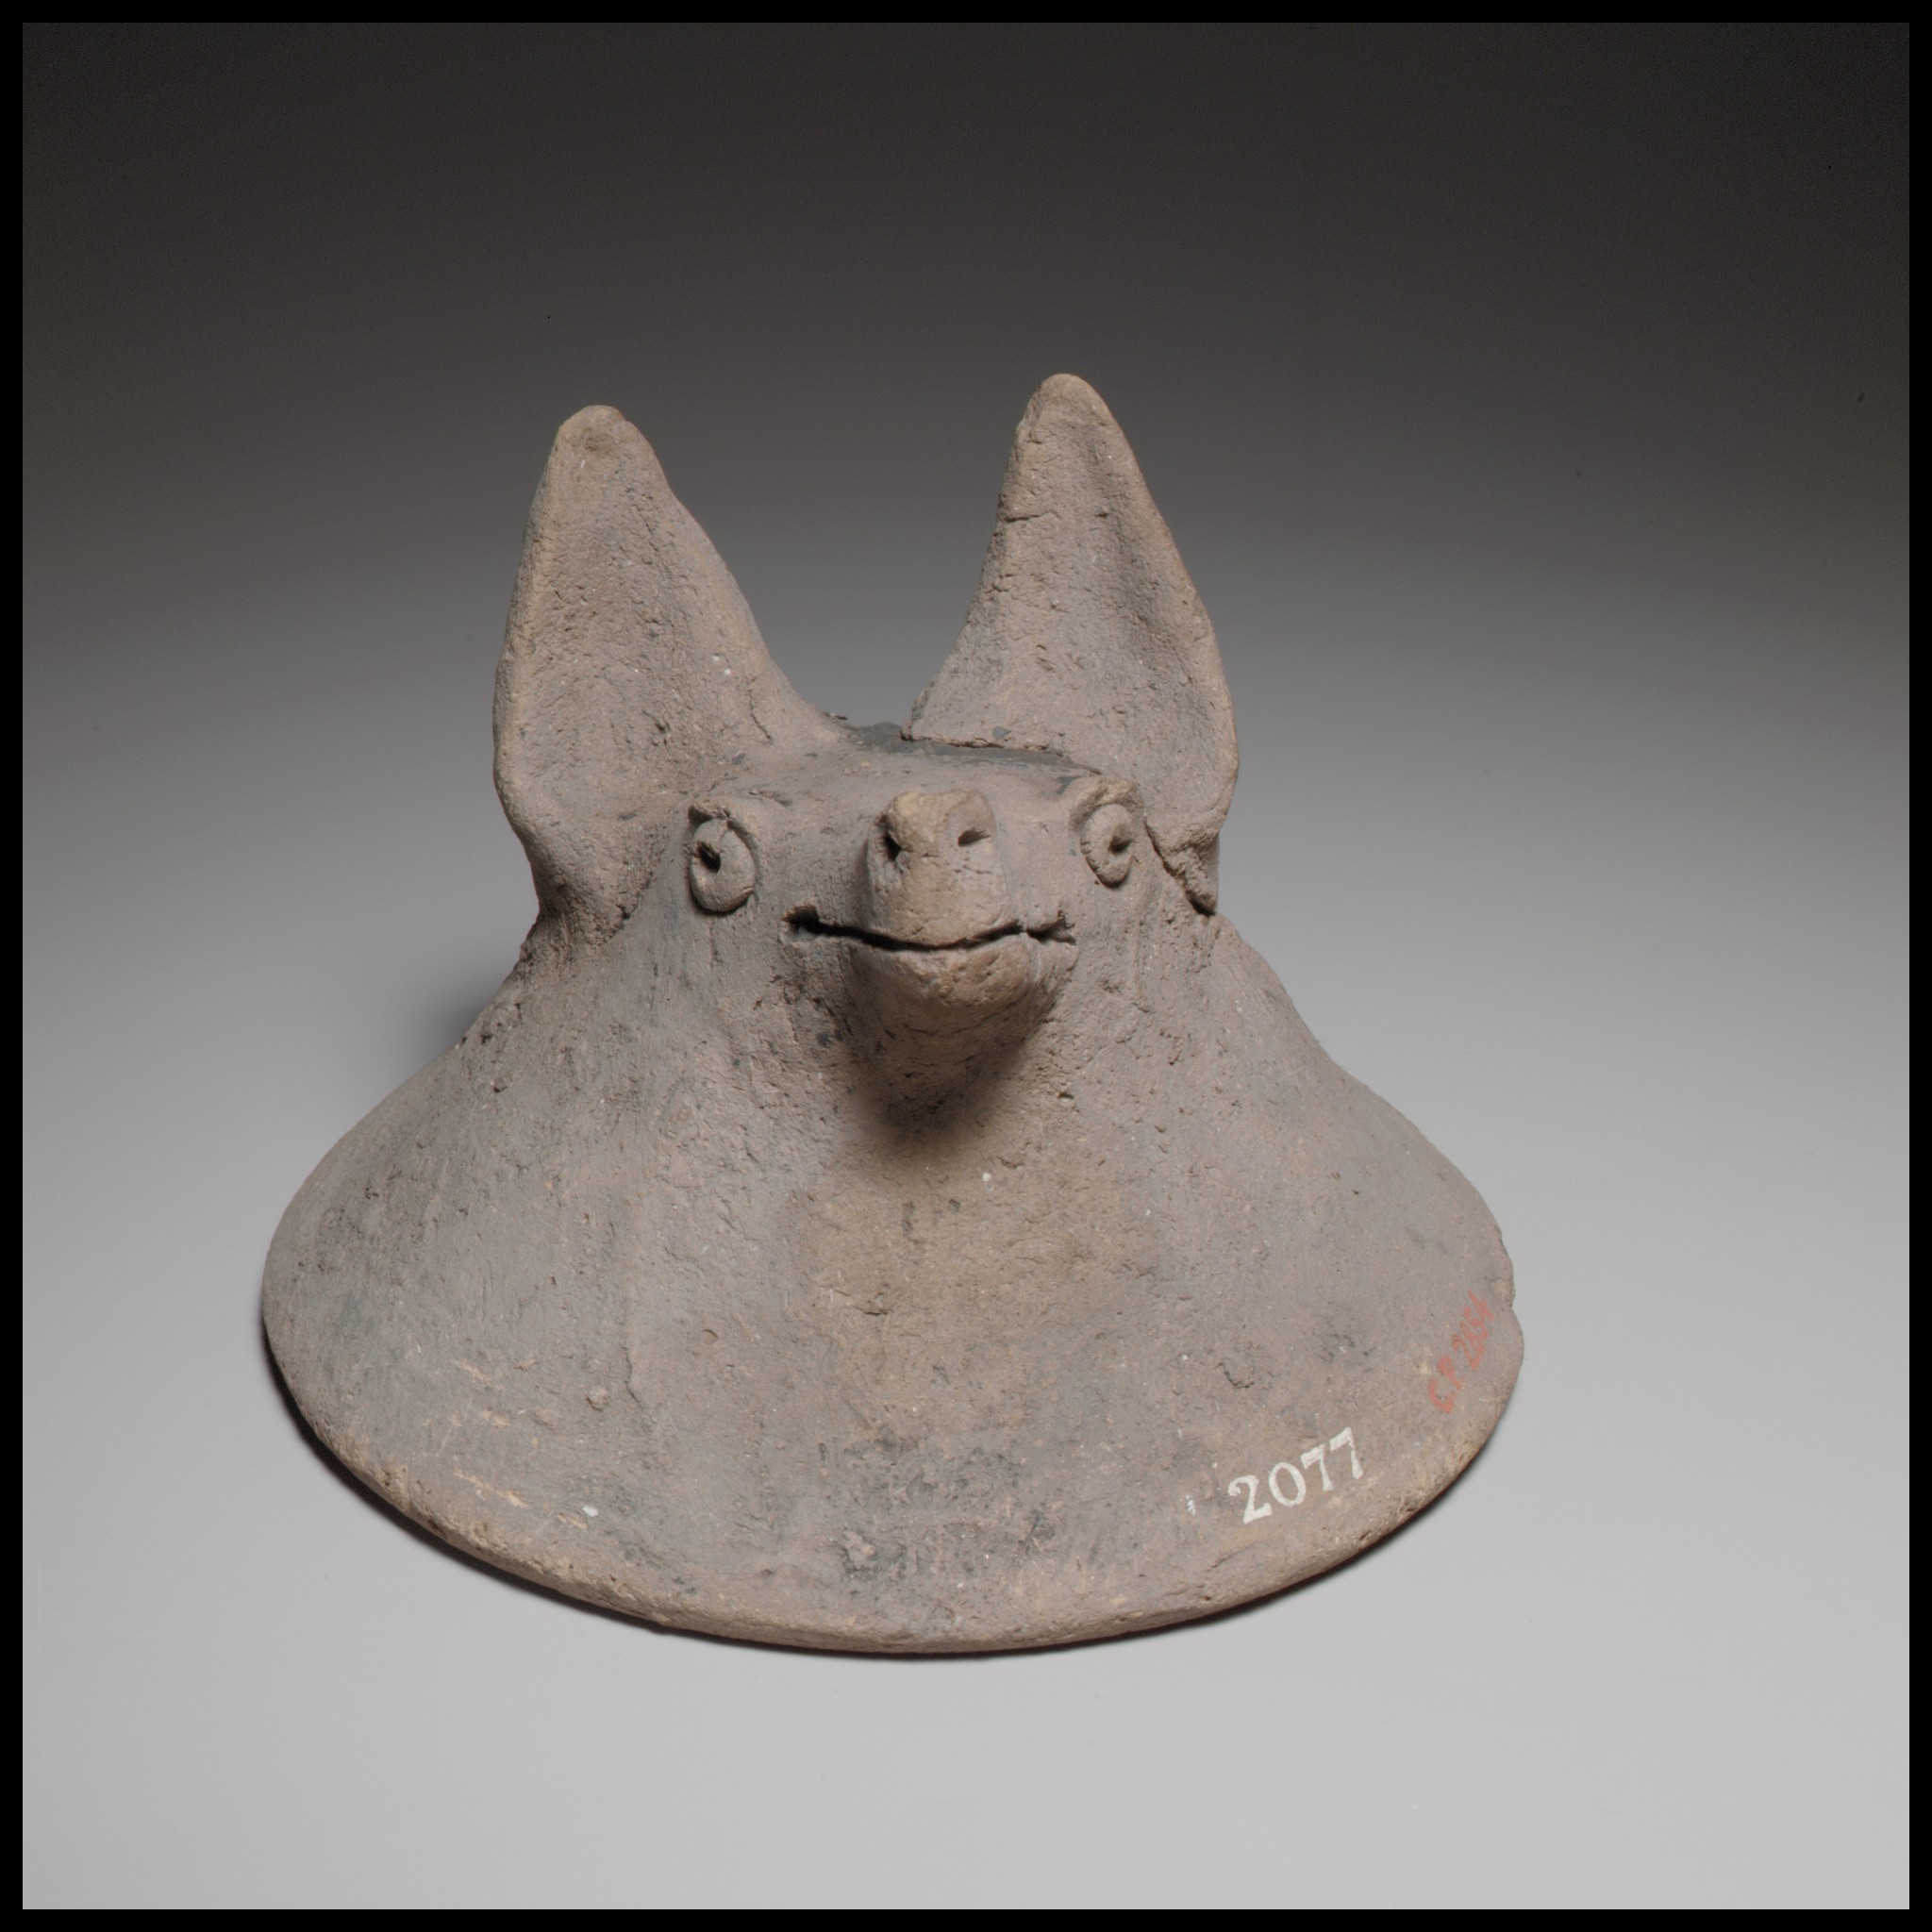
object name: mask of a bat, fox, or dog on medallion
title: Terracotta mask in the shape of the head of a fox, dog, or bat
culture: cypriot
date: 600-480 BCE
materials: terracotta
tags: masks